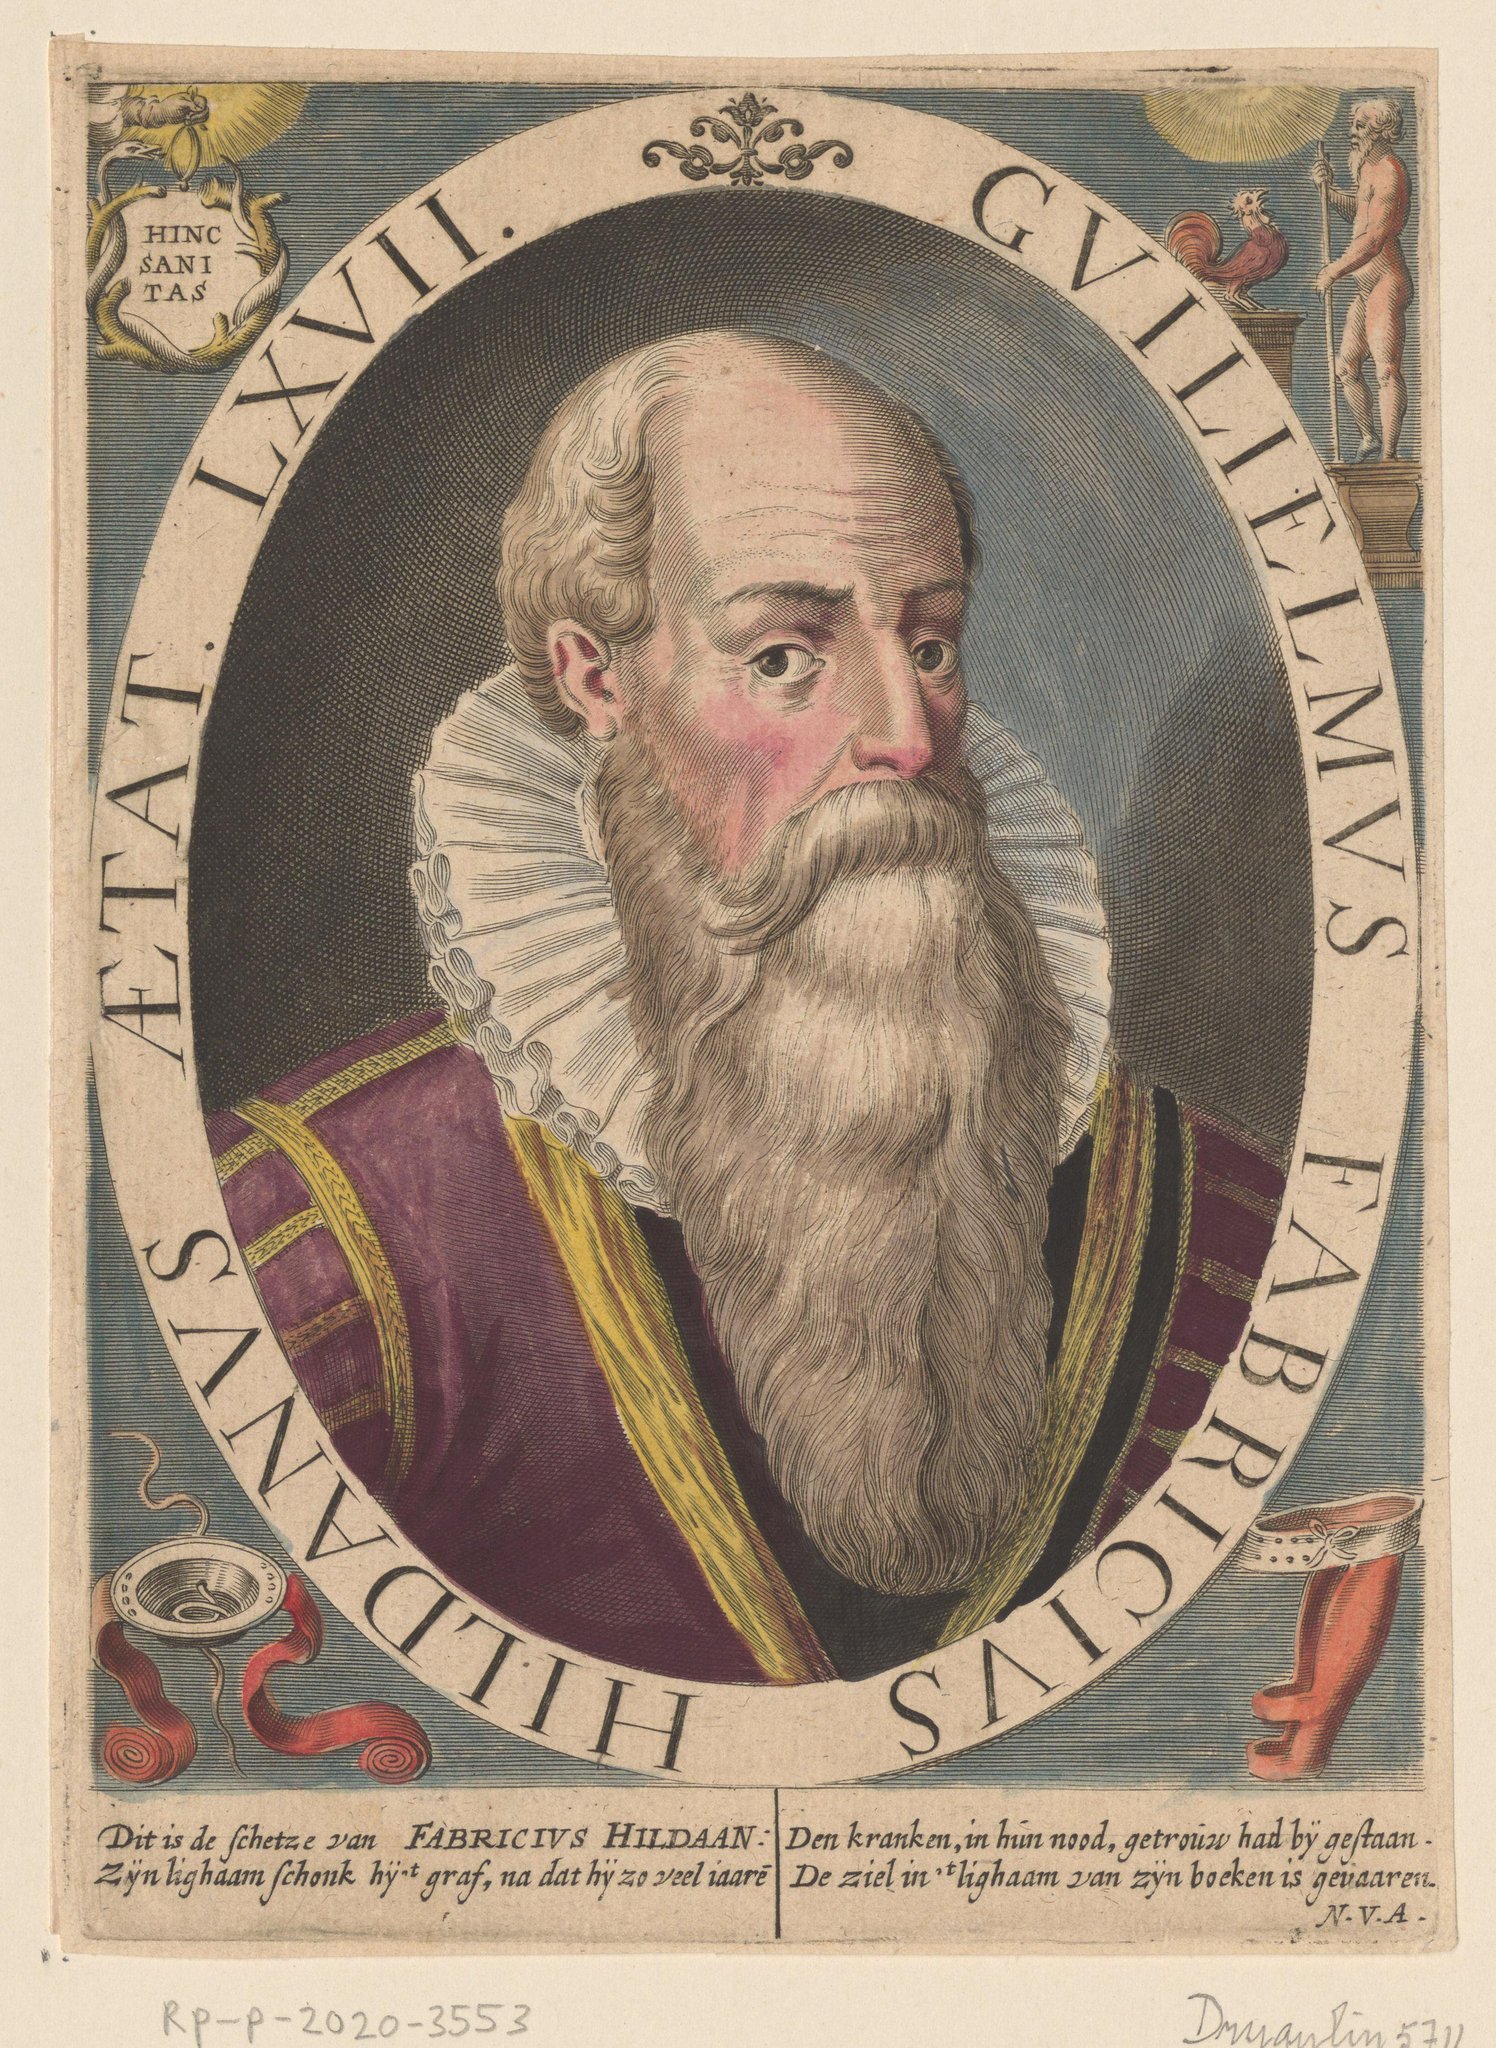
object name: print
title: Portret van Wilhelm Fabry op 67-jarige leeftijd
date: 1641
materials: paper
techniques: engraving, hand coloring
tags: historical persons, medical instruments, barber; surgeon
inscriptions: monogram: ‘N.V.A.’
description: Portret in andere staat gebruikt in: Fabry, Wilhelm. Observationum et curationum chirurgicarum (...). Lyon: Jean Antoine Huguetan, 1641.